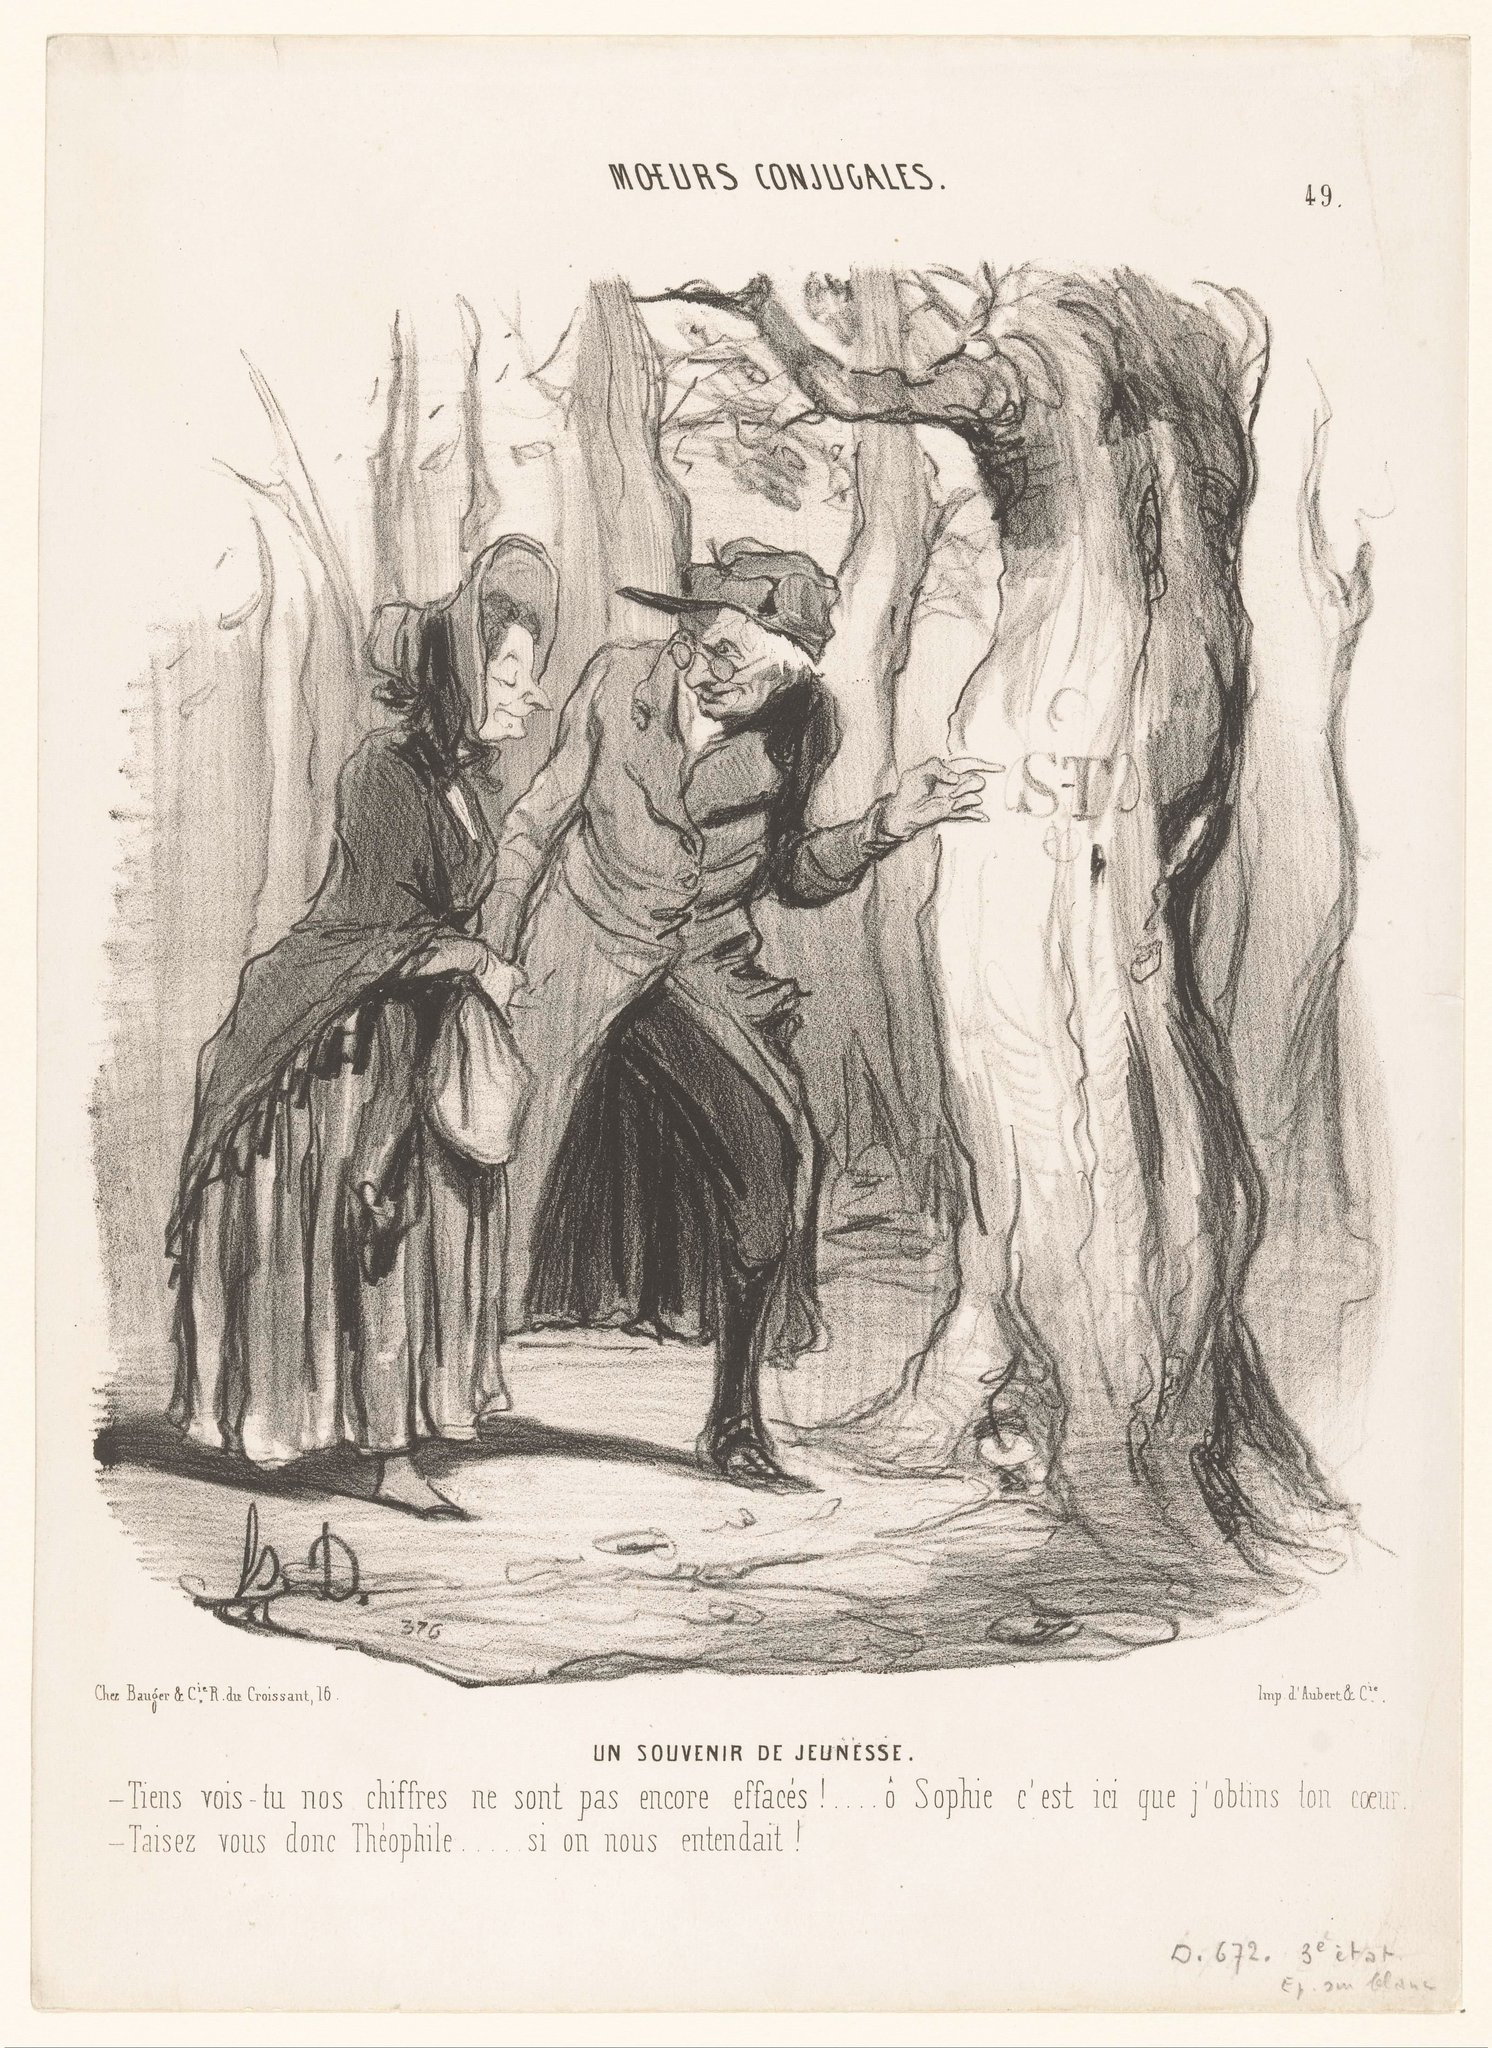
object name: cartoon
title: Un souvenir de jeunesse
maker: honoré daumier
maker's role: draughtsman, painter, print maker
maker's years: 1808-1879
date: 1842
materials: paper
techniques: letterpress printing, lithograph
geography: paris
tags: trees, caricatures (human types), the ages of man, happy marriage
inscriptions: collector's mark: Lugt 2228a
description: Prent mogelijk uit: La Caricature (3e serie), nr. 17, 24 april 1842.